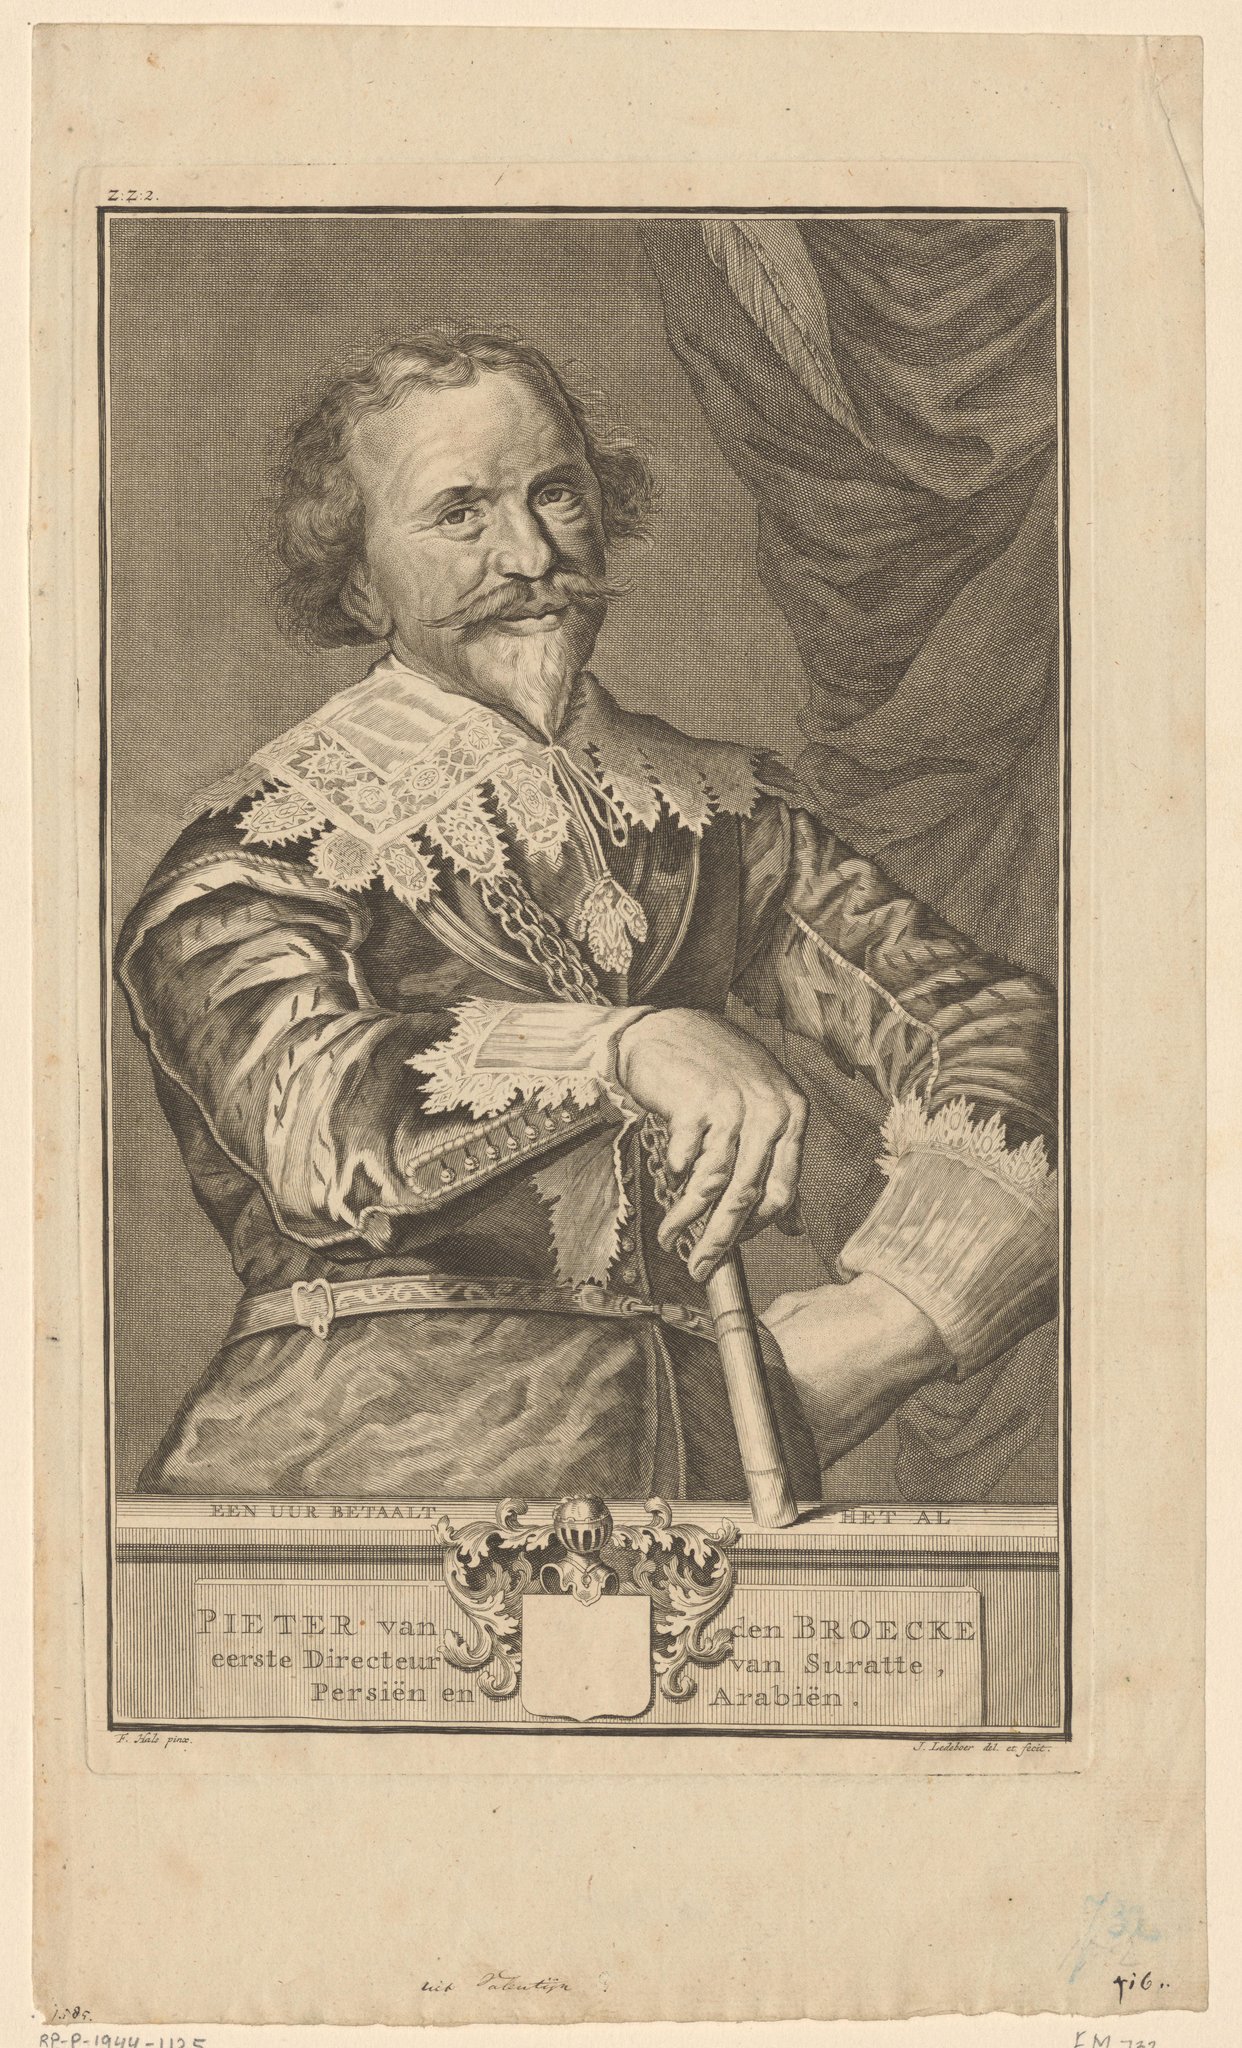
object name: print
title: Portret van Pieter van den Broecke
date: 1726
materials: paper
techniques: engraving, etching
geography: amsterdam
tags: antwerp, pieter van den broecke, historical persons, baton of general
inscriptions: collector's mark: Lugt 2228, inscription: ‘1585 uit Valentijn +16..’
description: Prent uit: Valentijn, François. Oud en nieuw Oost-Indien, vervattende een naaukeurige en uitvoerige verhandelinge van Nederlands mogentheyd in die gewesten (...). Dordrecht en Amsterdam: Johannes van Braam en Gerard onder de Linden, 1726, dl. 4.2.